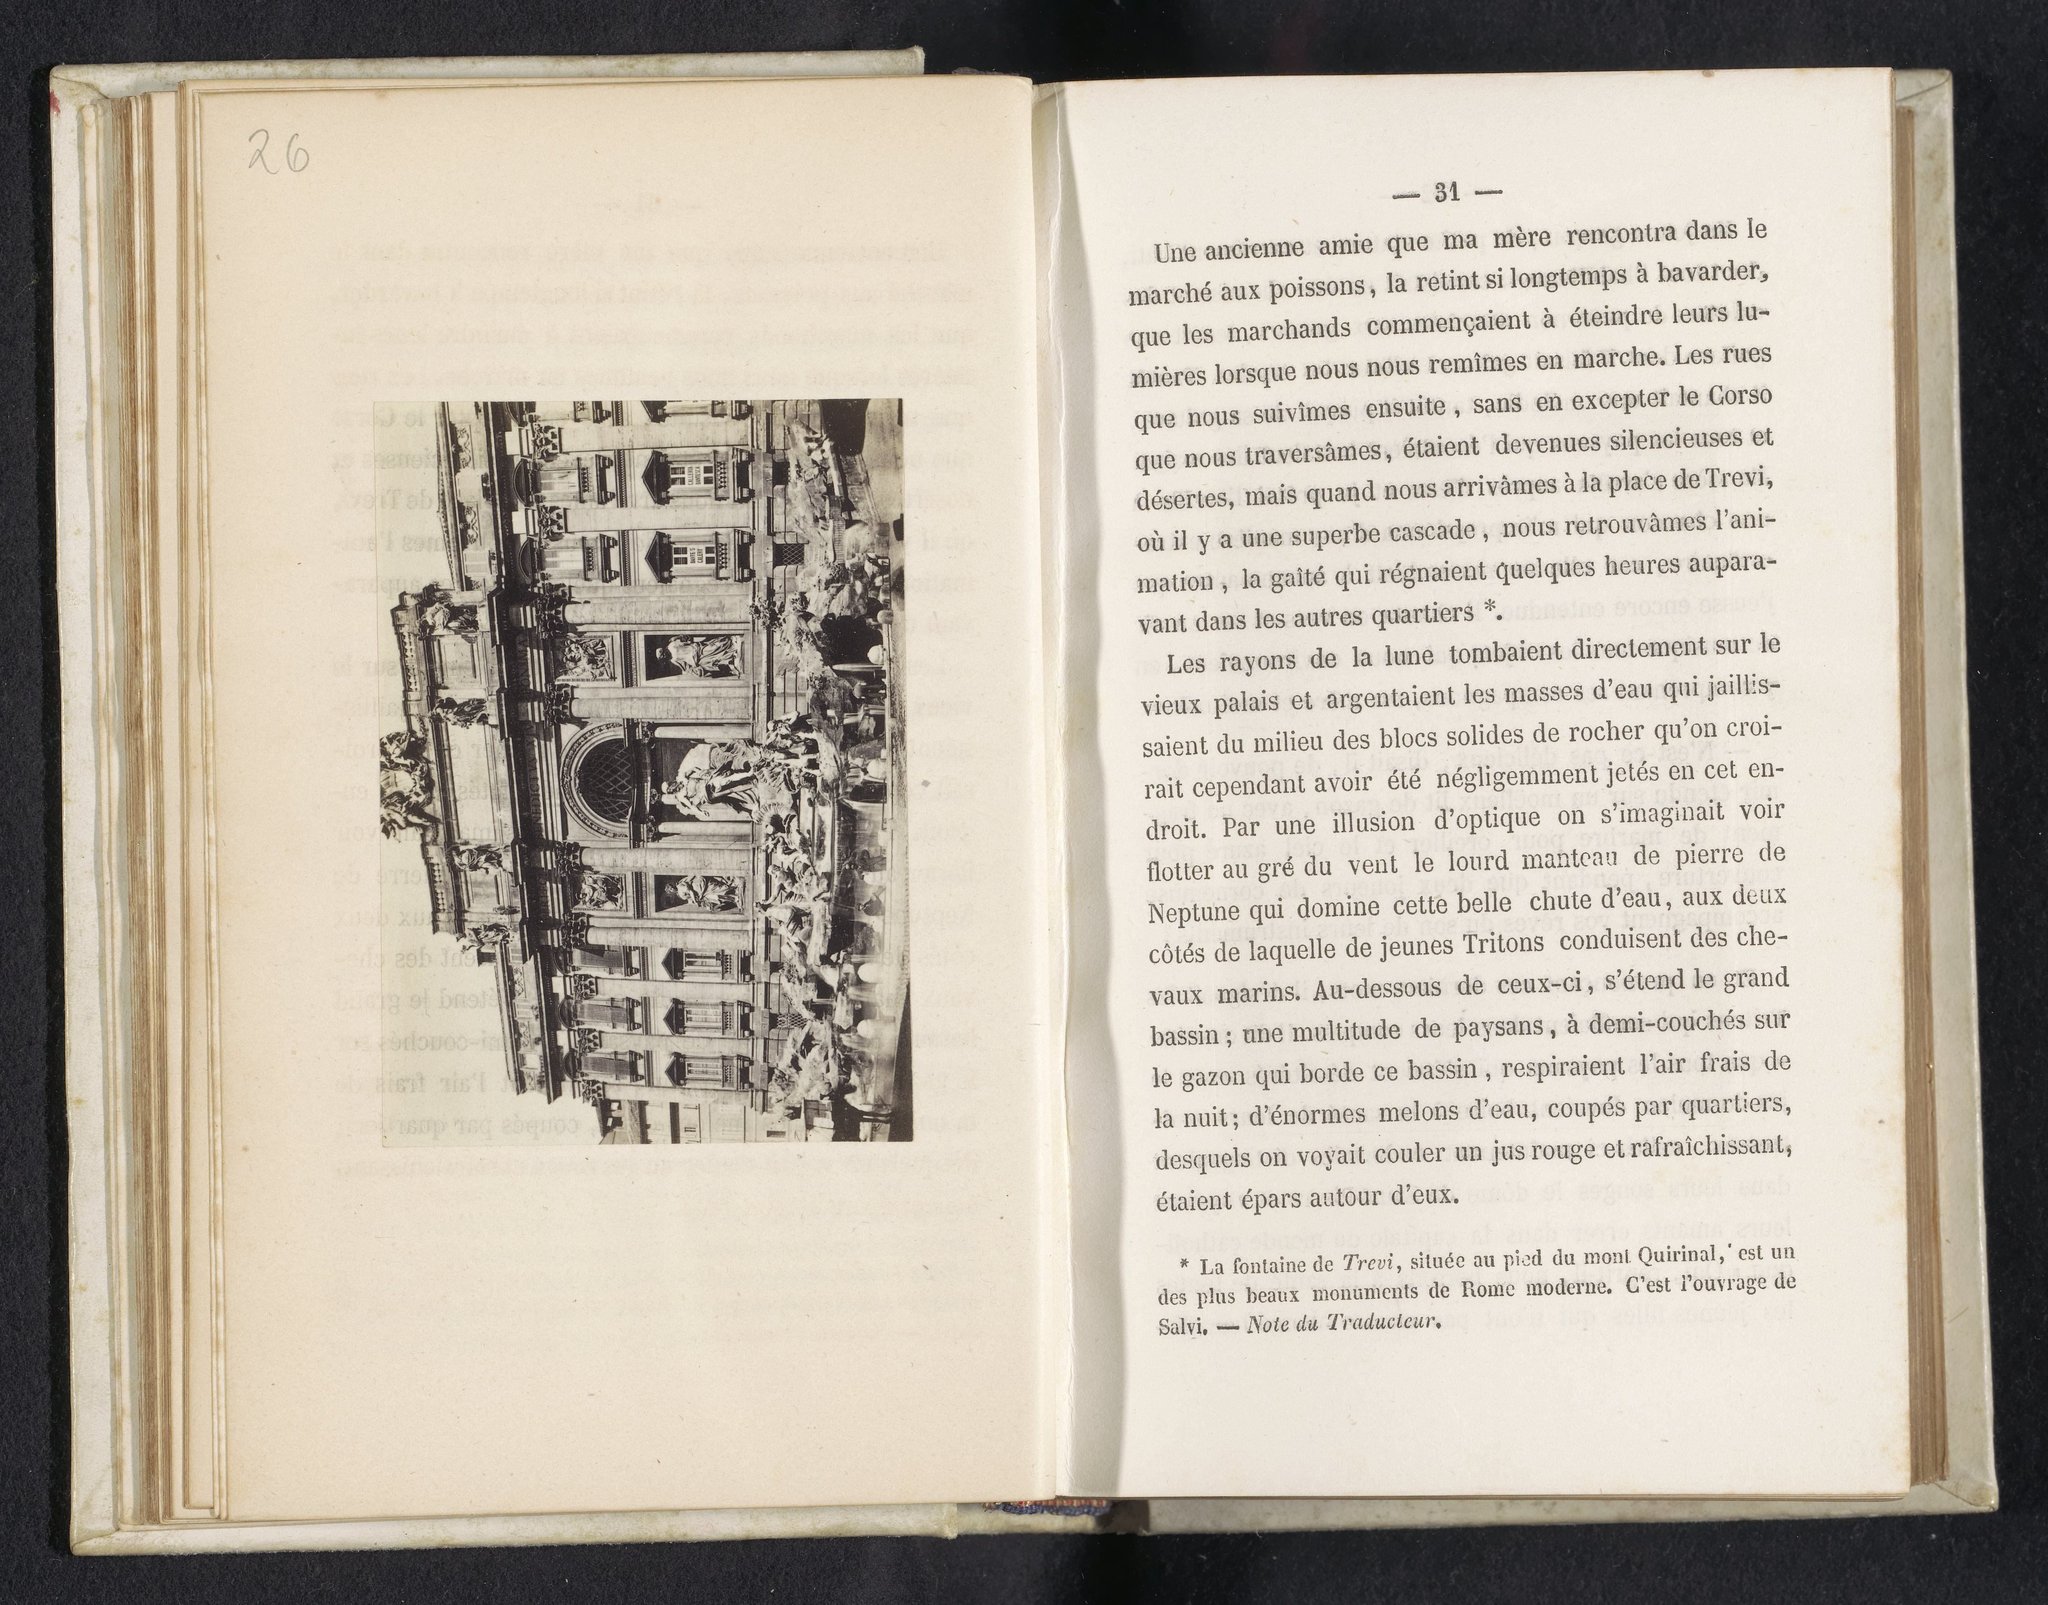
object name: photograph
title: Trevifontein te Rome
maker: Anonymous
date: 1850-1860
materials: photographic support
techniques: albumen print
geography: rome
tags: ornamental fountain